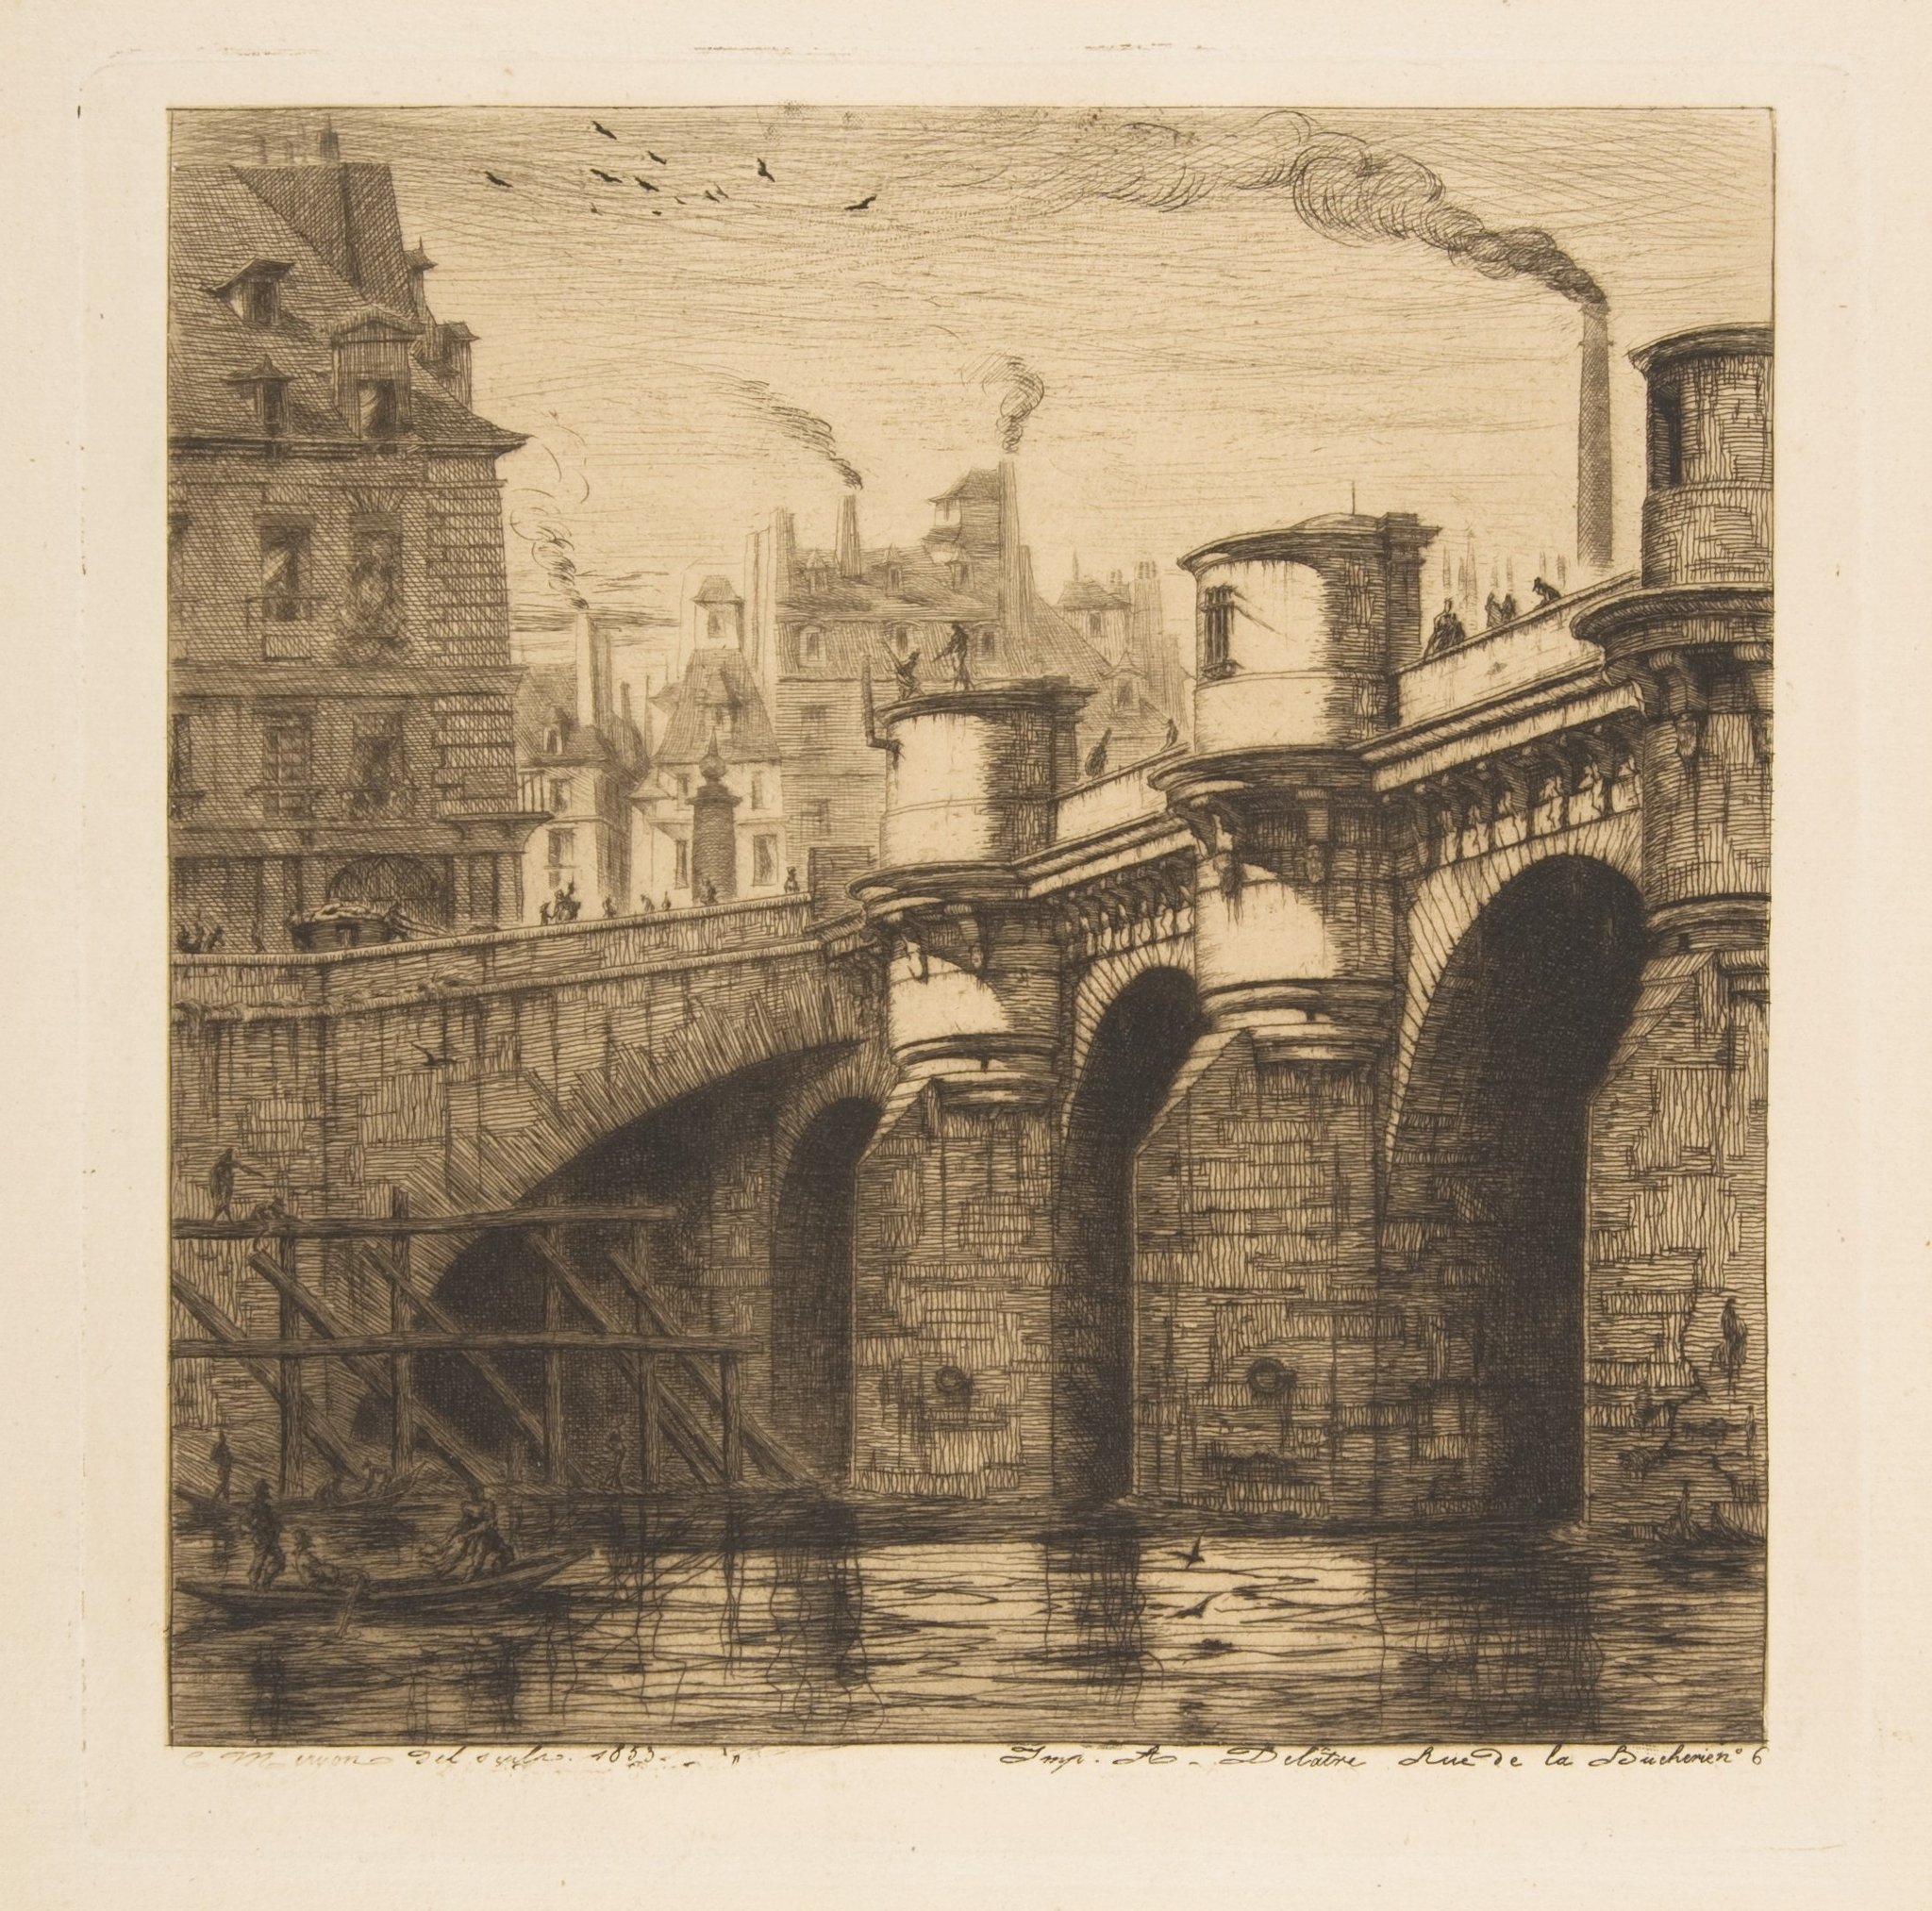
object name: print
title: Pont-Neuf, Paris, from "Etchings of Paris"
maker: charles meryon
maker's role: artist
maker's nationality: french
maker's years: 1821-1868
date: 1853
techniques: drypoint, etching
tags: arches,bridges,paris